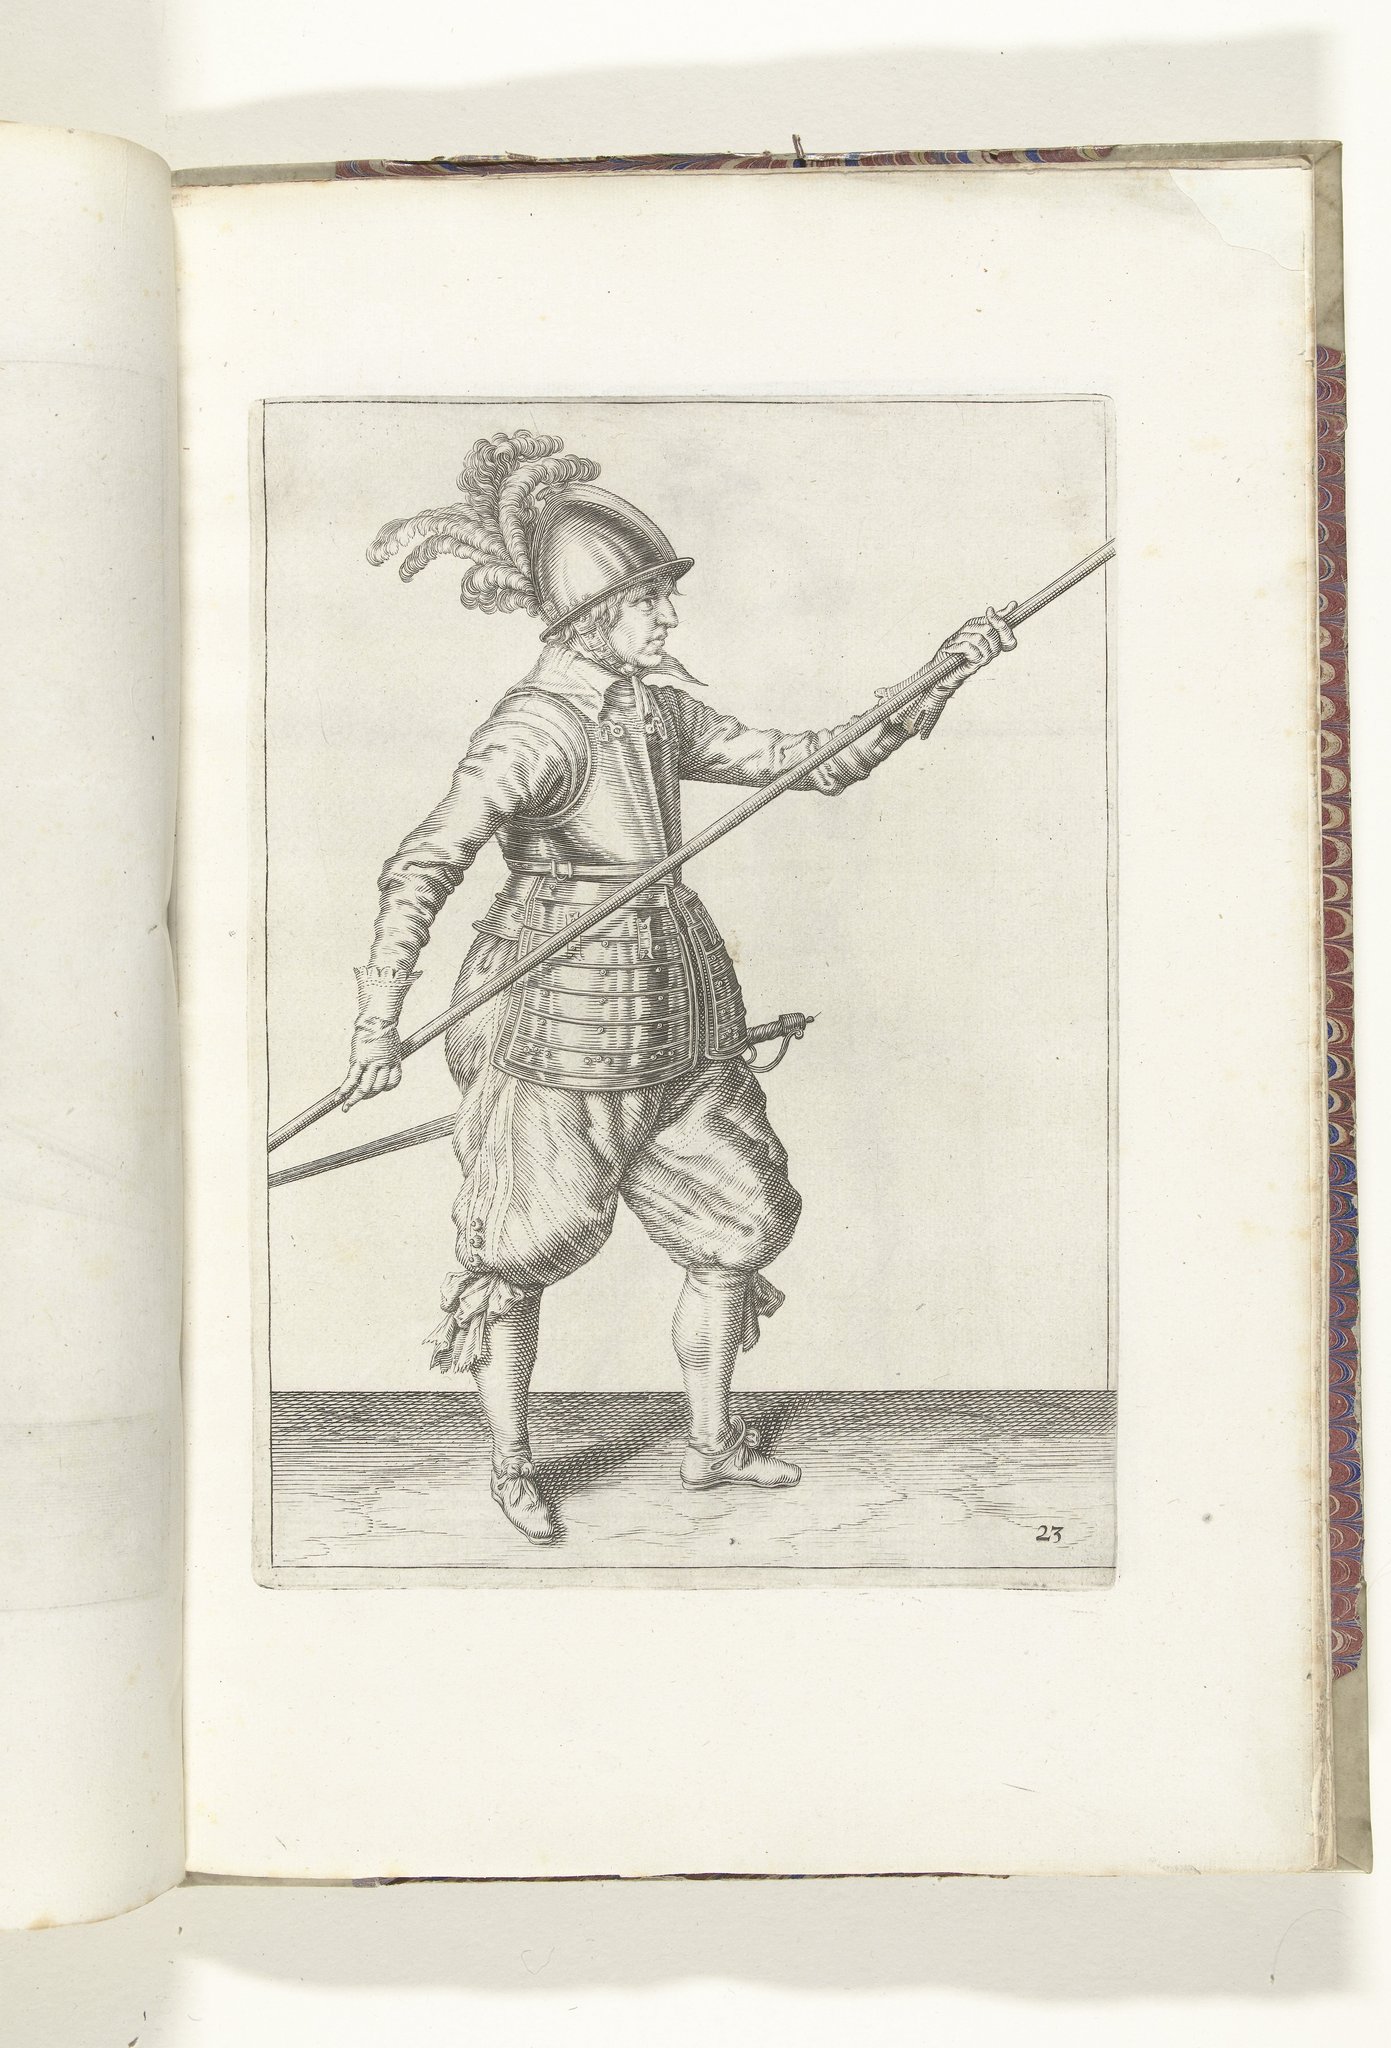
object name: print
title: Soldaat die zijn spies naar voren steekt door zijn rechterhand over te brengen van de punt naar de voet van het wapen (nr. 23), ca. 1600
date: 1597-1607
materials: paper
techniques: engraving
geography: amsterdam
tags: the hague, maurice (prince of orange), handling of weapons ~ military training, weapons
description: Illustratie in: J. de Gheyn, Wapenhandelinghe van roers, musquetten ende spiessen achtervolgende de ordre van ... Maurits Prince van Orangie ..., R. de Baudous, Amsterdam 1608. Het derde deel (met afgesneden platen): Corte onderwysinghe op de figuerliicke afbeeldinghe belanghende trechte gebruck, van alle t'ghene een Soldaet int handelen vande Spies noodich is, plaat 23. Dit exemplaar bevat alleen de tekstbladen voor het tweede en derde deel. In het exemplaar in de collectie van de Rijksmuseum Research Library (326 F 16).